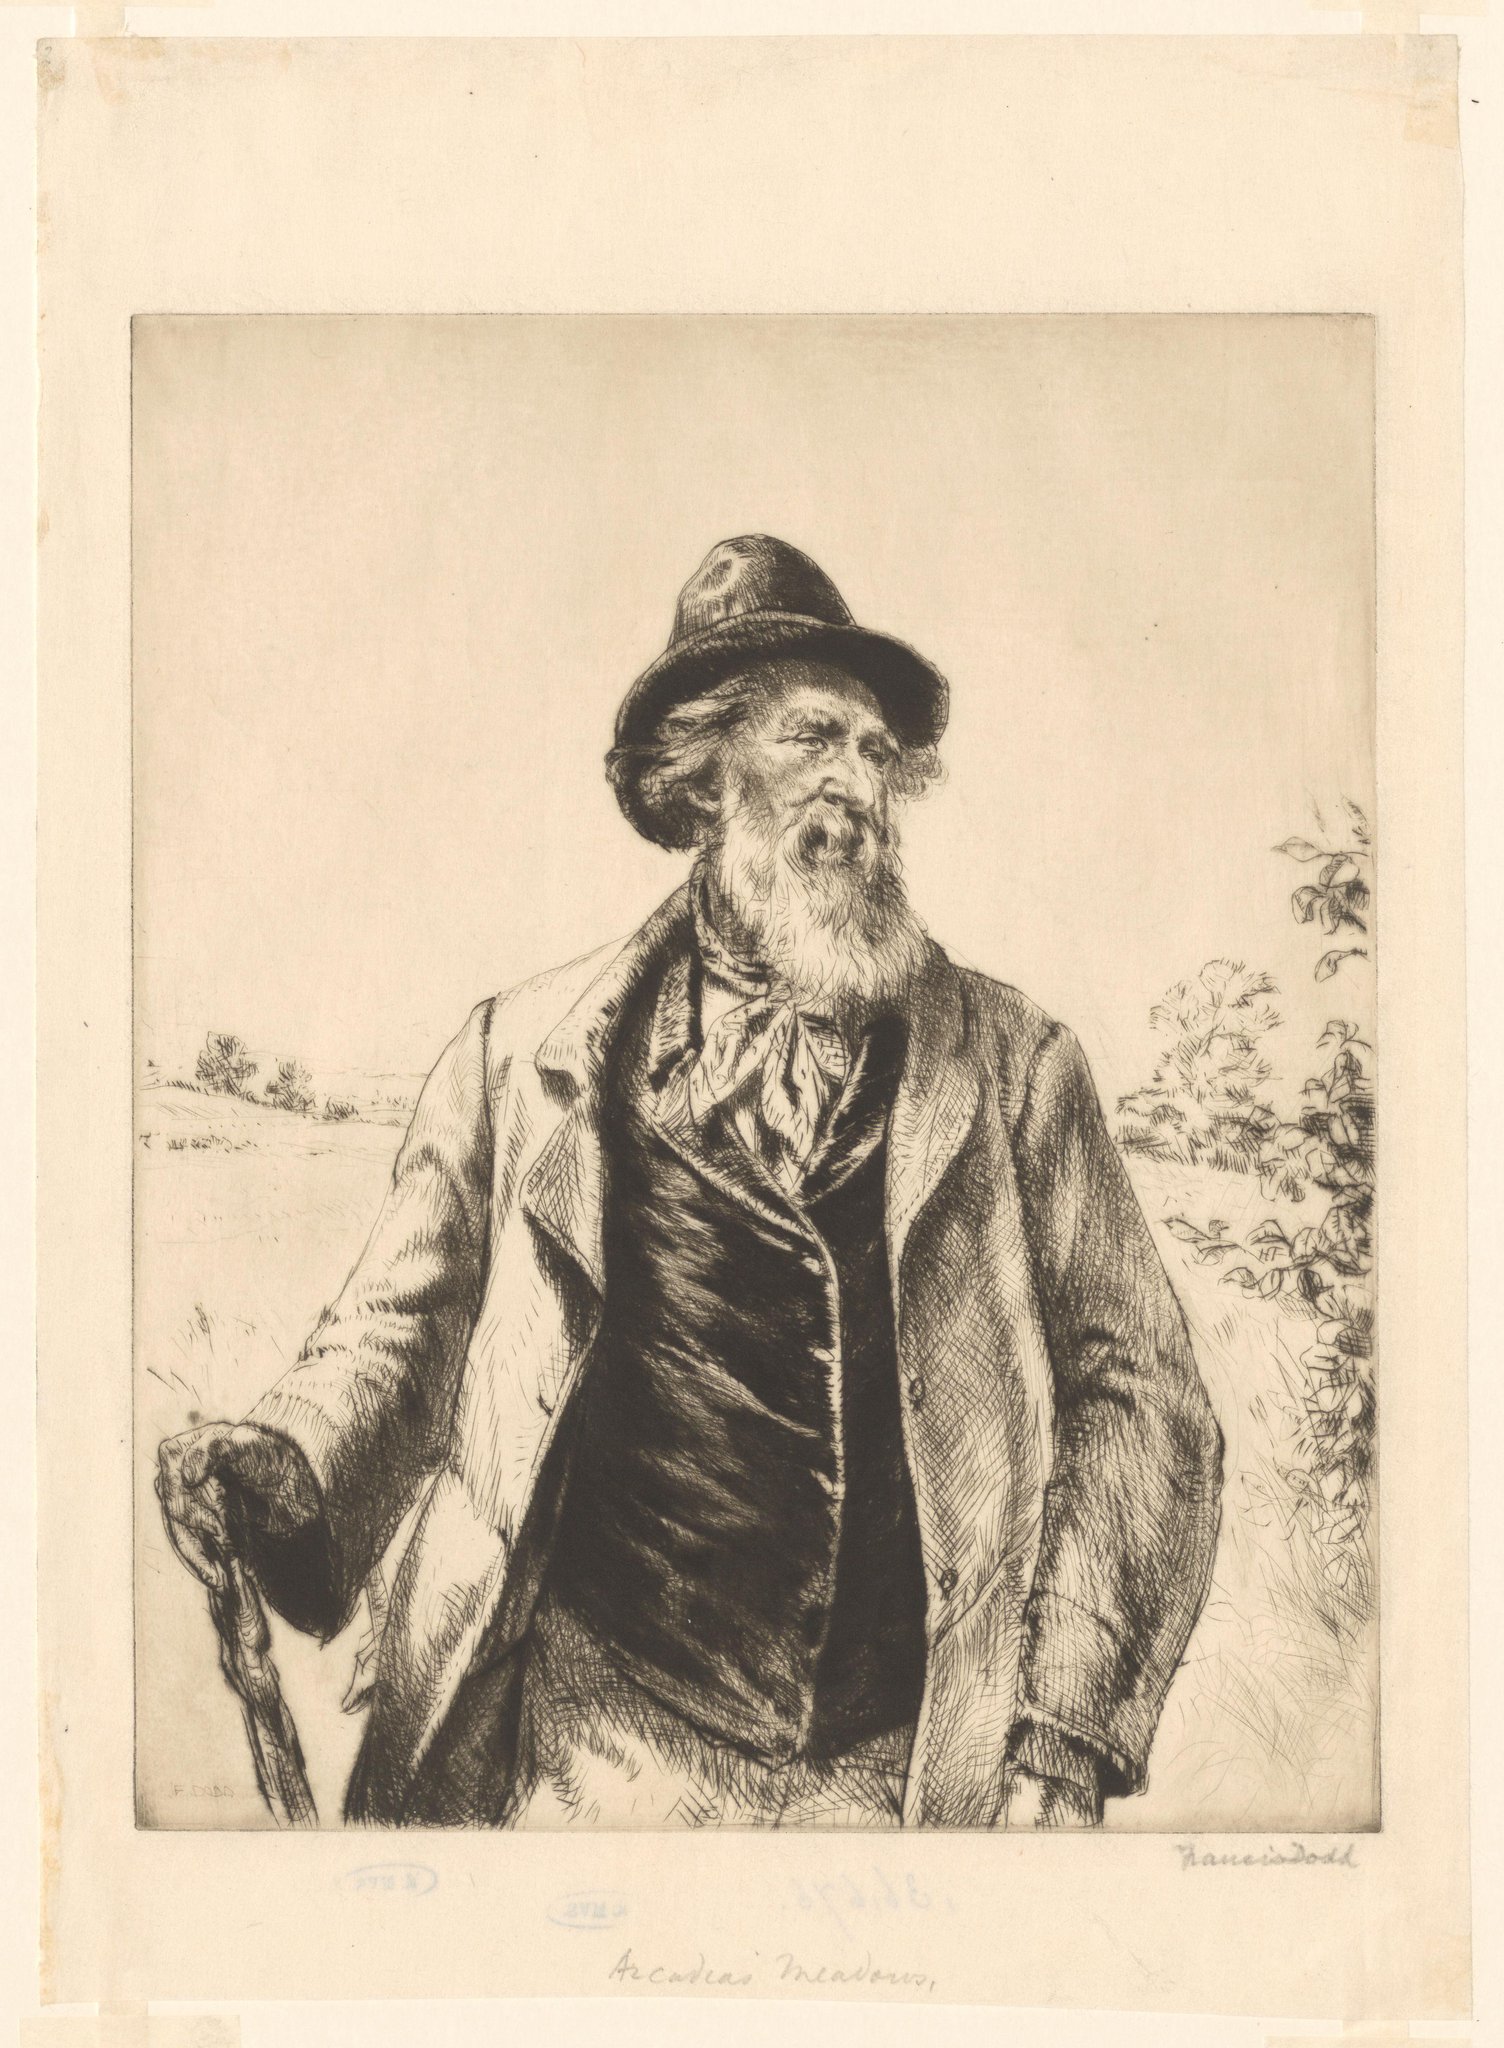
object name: print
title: Portret van een onbekende oude man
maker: francis dodd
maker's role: print maker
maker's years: 1874-1949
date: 1884-1936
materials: paper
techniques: drypoint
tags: historical persons, cattle driving, cattle driver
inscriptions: annotation: ‘Arcadia's Meadows’, collector's mark: Lugt 2228, collector's mark: Lugt 2228